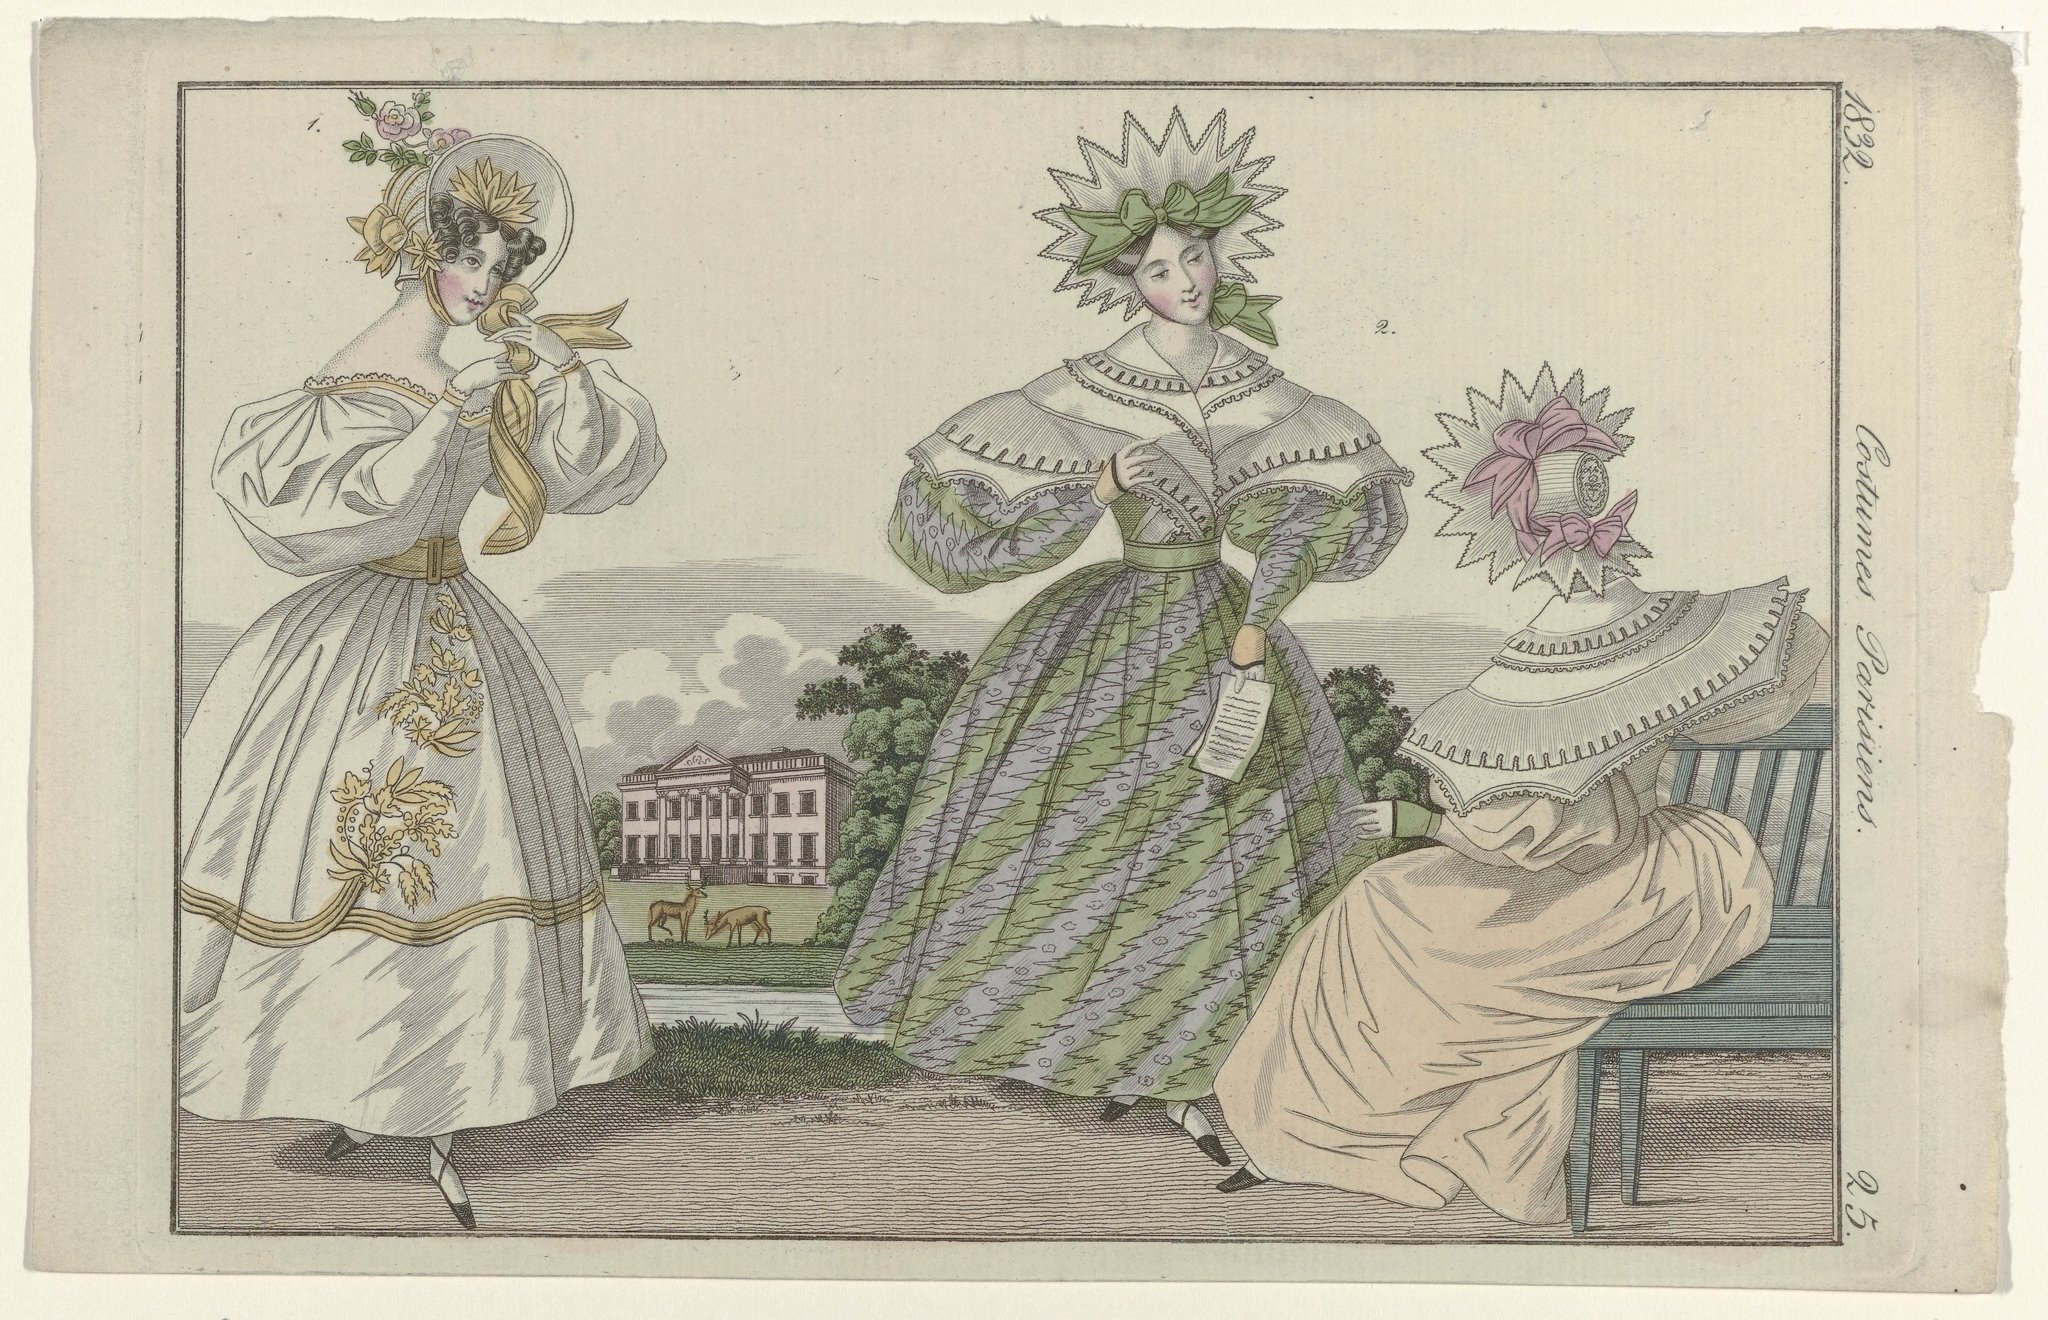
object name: fashion print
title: Journal des Dames et des Modes, editie Frankfurt, 1832, Costumes Parisiens, No. 25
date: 1832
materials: paper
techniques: engraving, hand coloring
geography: frankfurt am main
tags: clothing for the upper part of the body (+ women's clothes), rural housing, e.g. country-house, villa, cottage, head-gear: cap (+ women's clothes), fashion plates, shoes, sandals (+ women's clothes), dress, gown (+ women's clothes), letter, envelope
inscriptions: title: ‘Costumes Parisiens.’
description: Drie vrouwen, genummerd 1 en 2, gekleed in japonnen met schapenboutmouwen. Luifelhoed versierd met bloemen en lint. Muts met gekartelde zoom en versierd met lint. Op de achtergrond een landhuis en twee herten. Prent uit het modetijdschrift Journal des Dames et des Modes, Frankfurt-am-Main, 1798-1848.